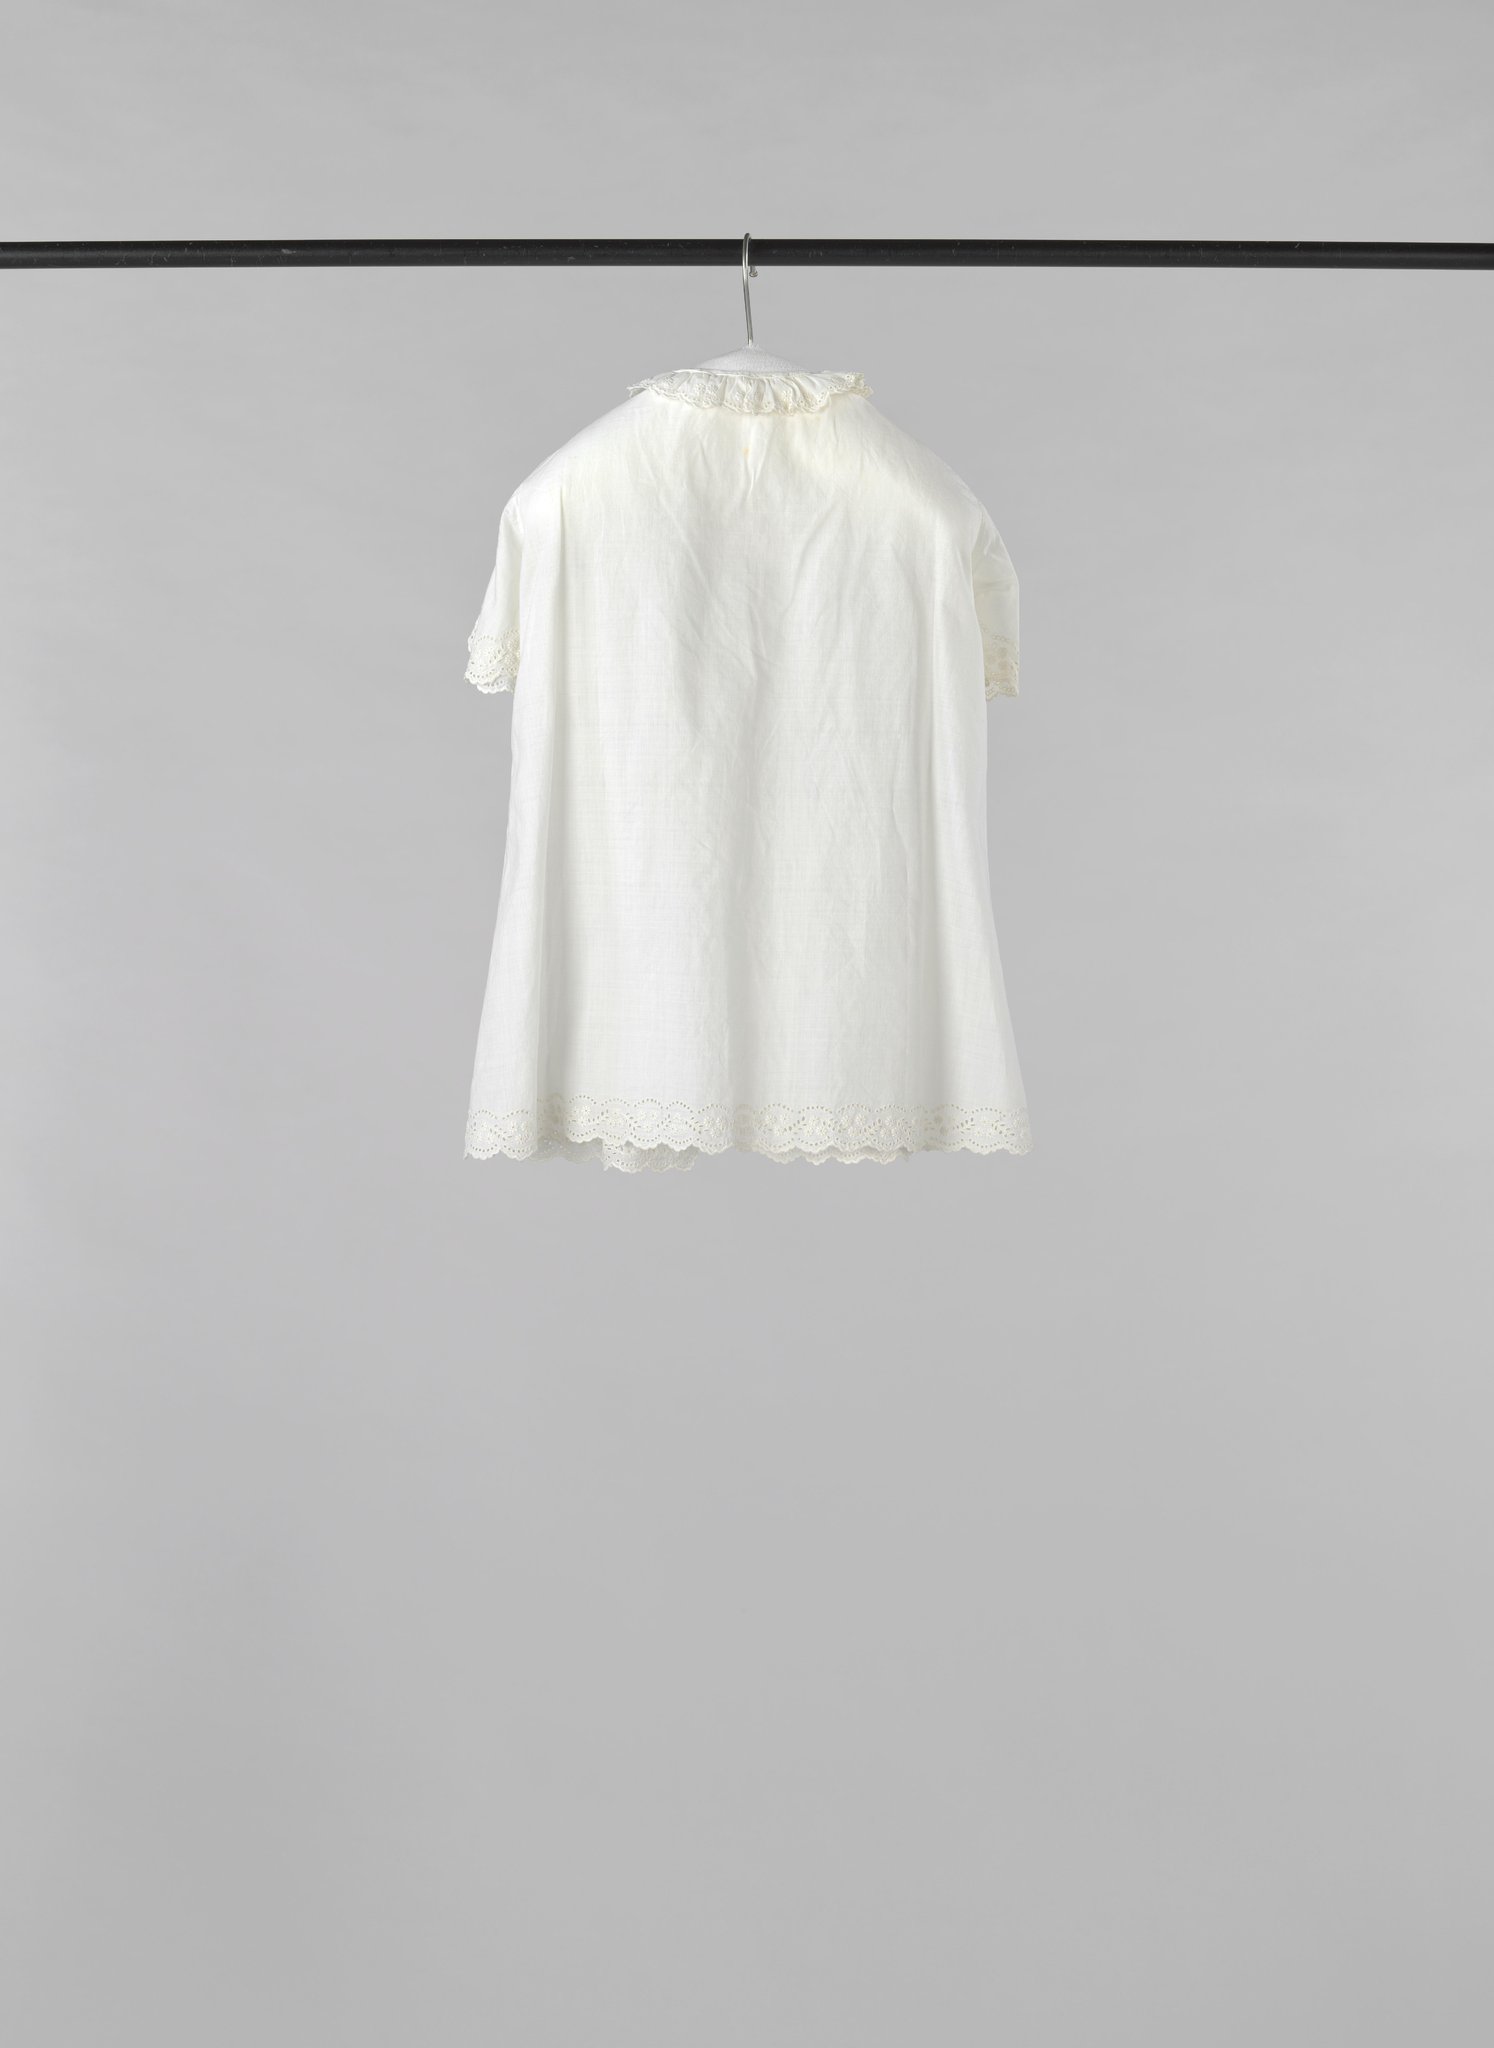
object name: jak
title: Een kinderjakje van batist met geborduurde randen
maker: Anonymous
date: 1860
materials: textile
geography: netherlands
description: Een kinderjakje van batist met geborduurde randen.